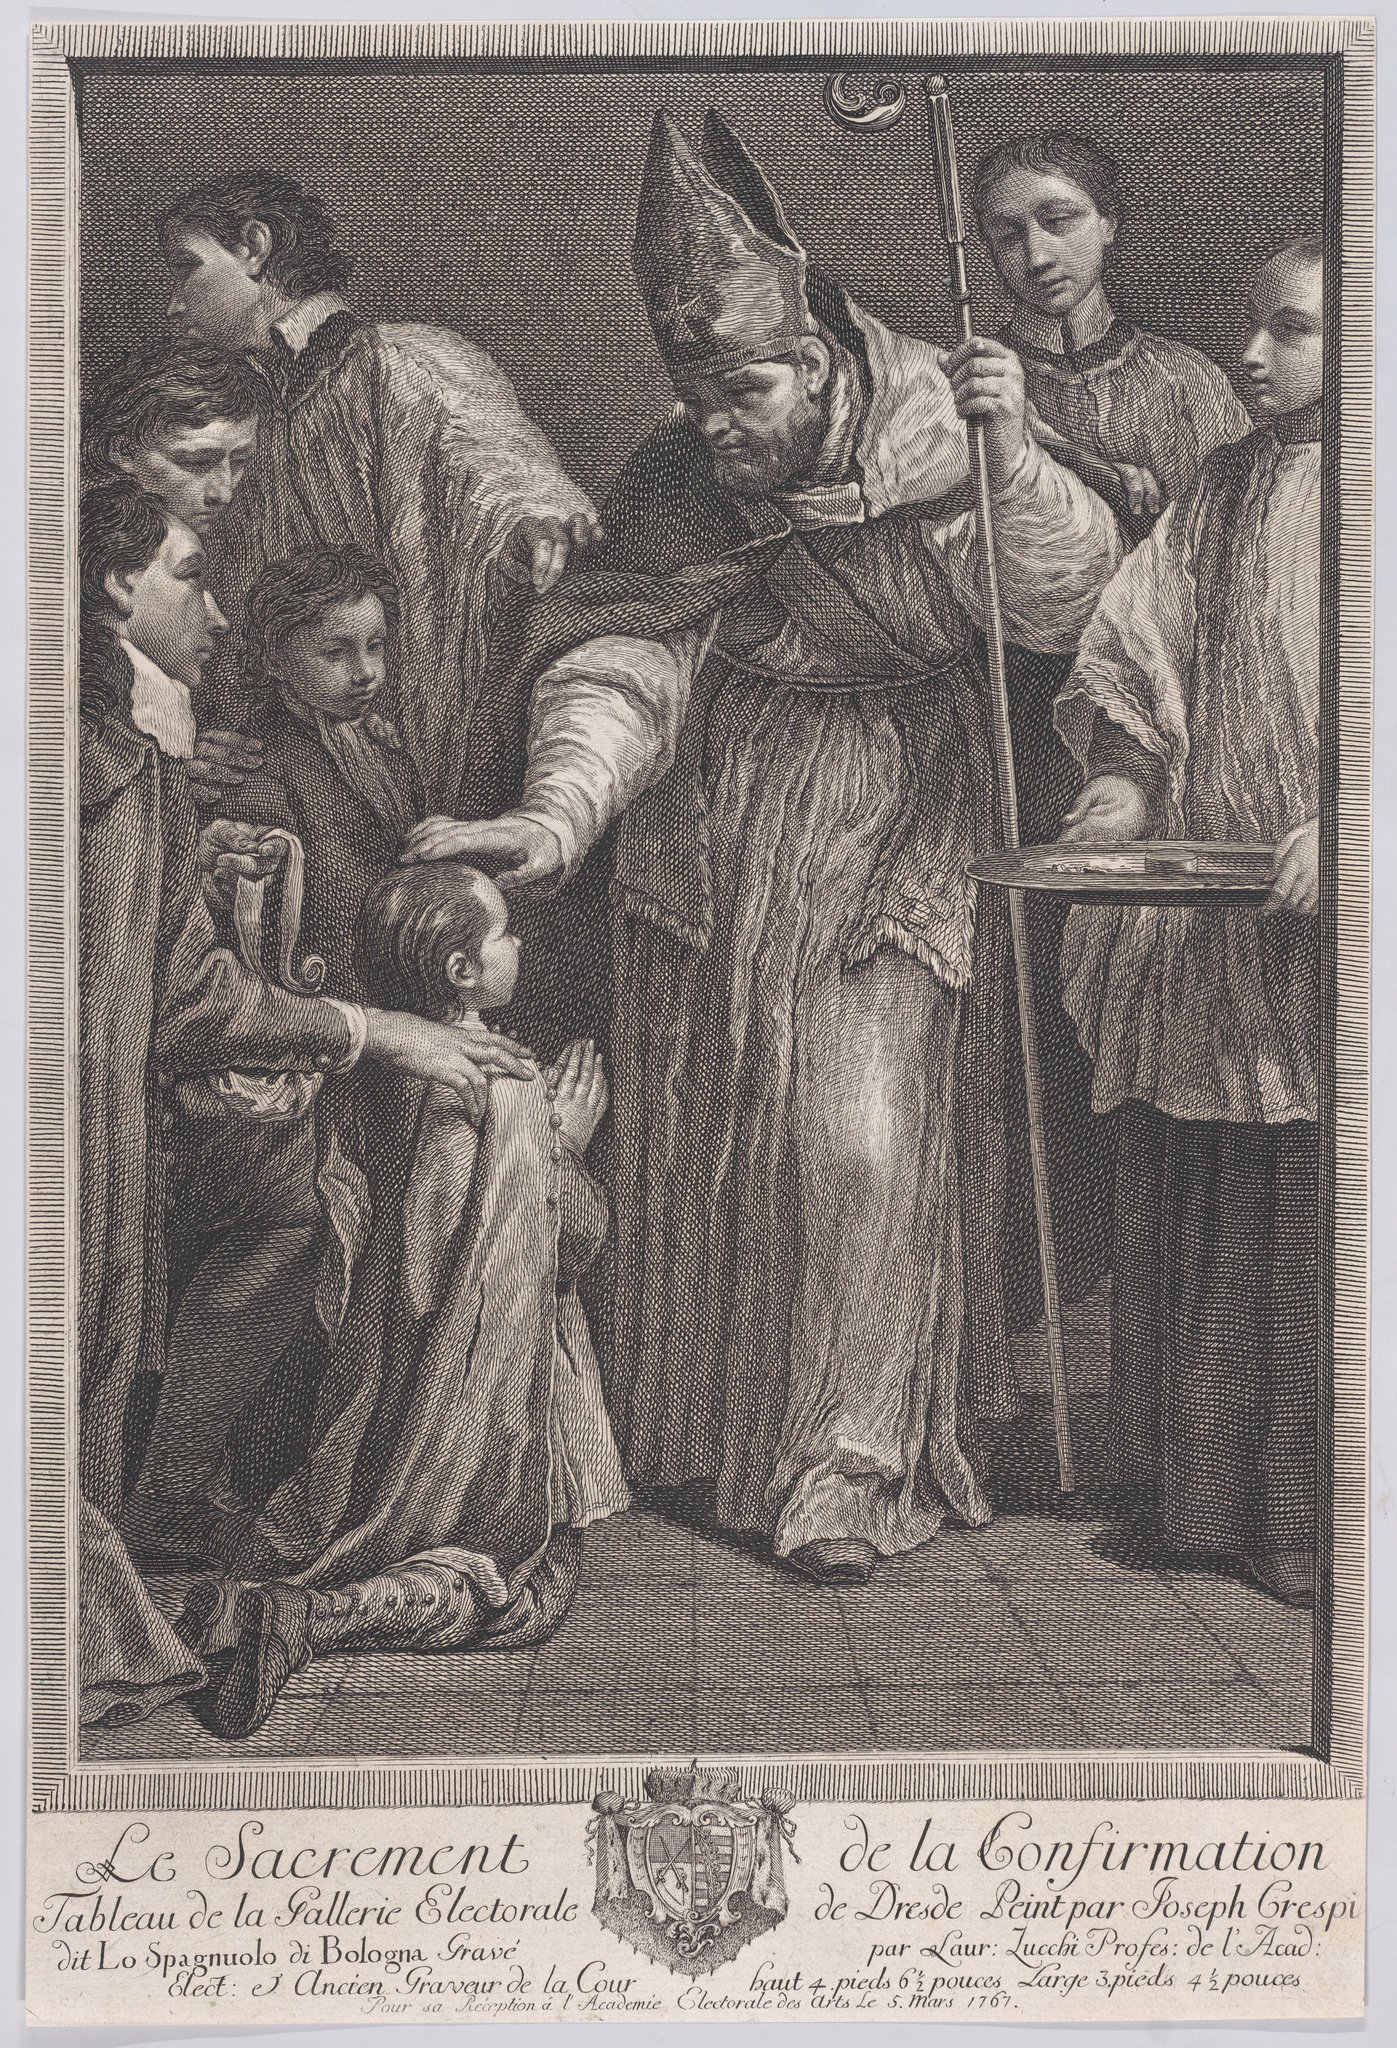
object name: print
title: Confirmation, from "The Seven Sacraments"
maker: lorenzo zucchi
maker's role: artist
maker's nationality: italian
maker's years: 1704-1779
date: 1767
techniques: etching